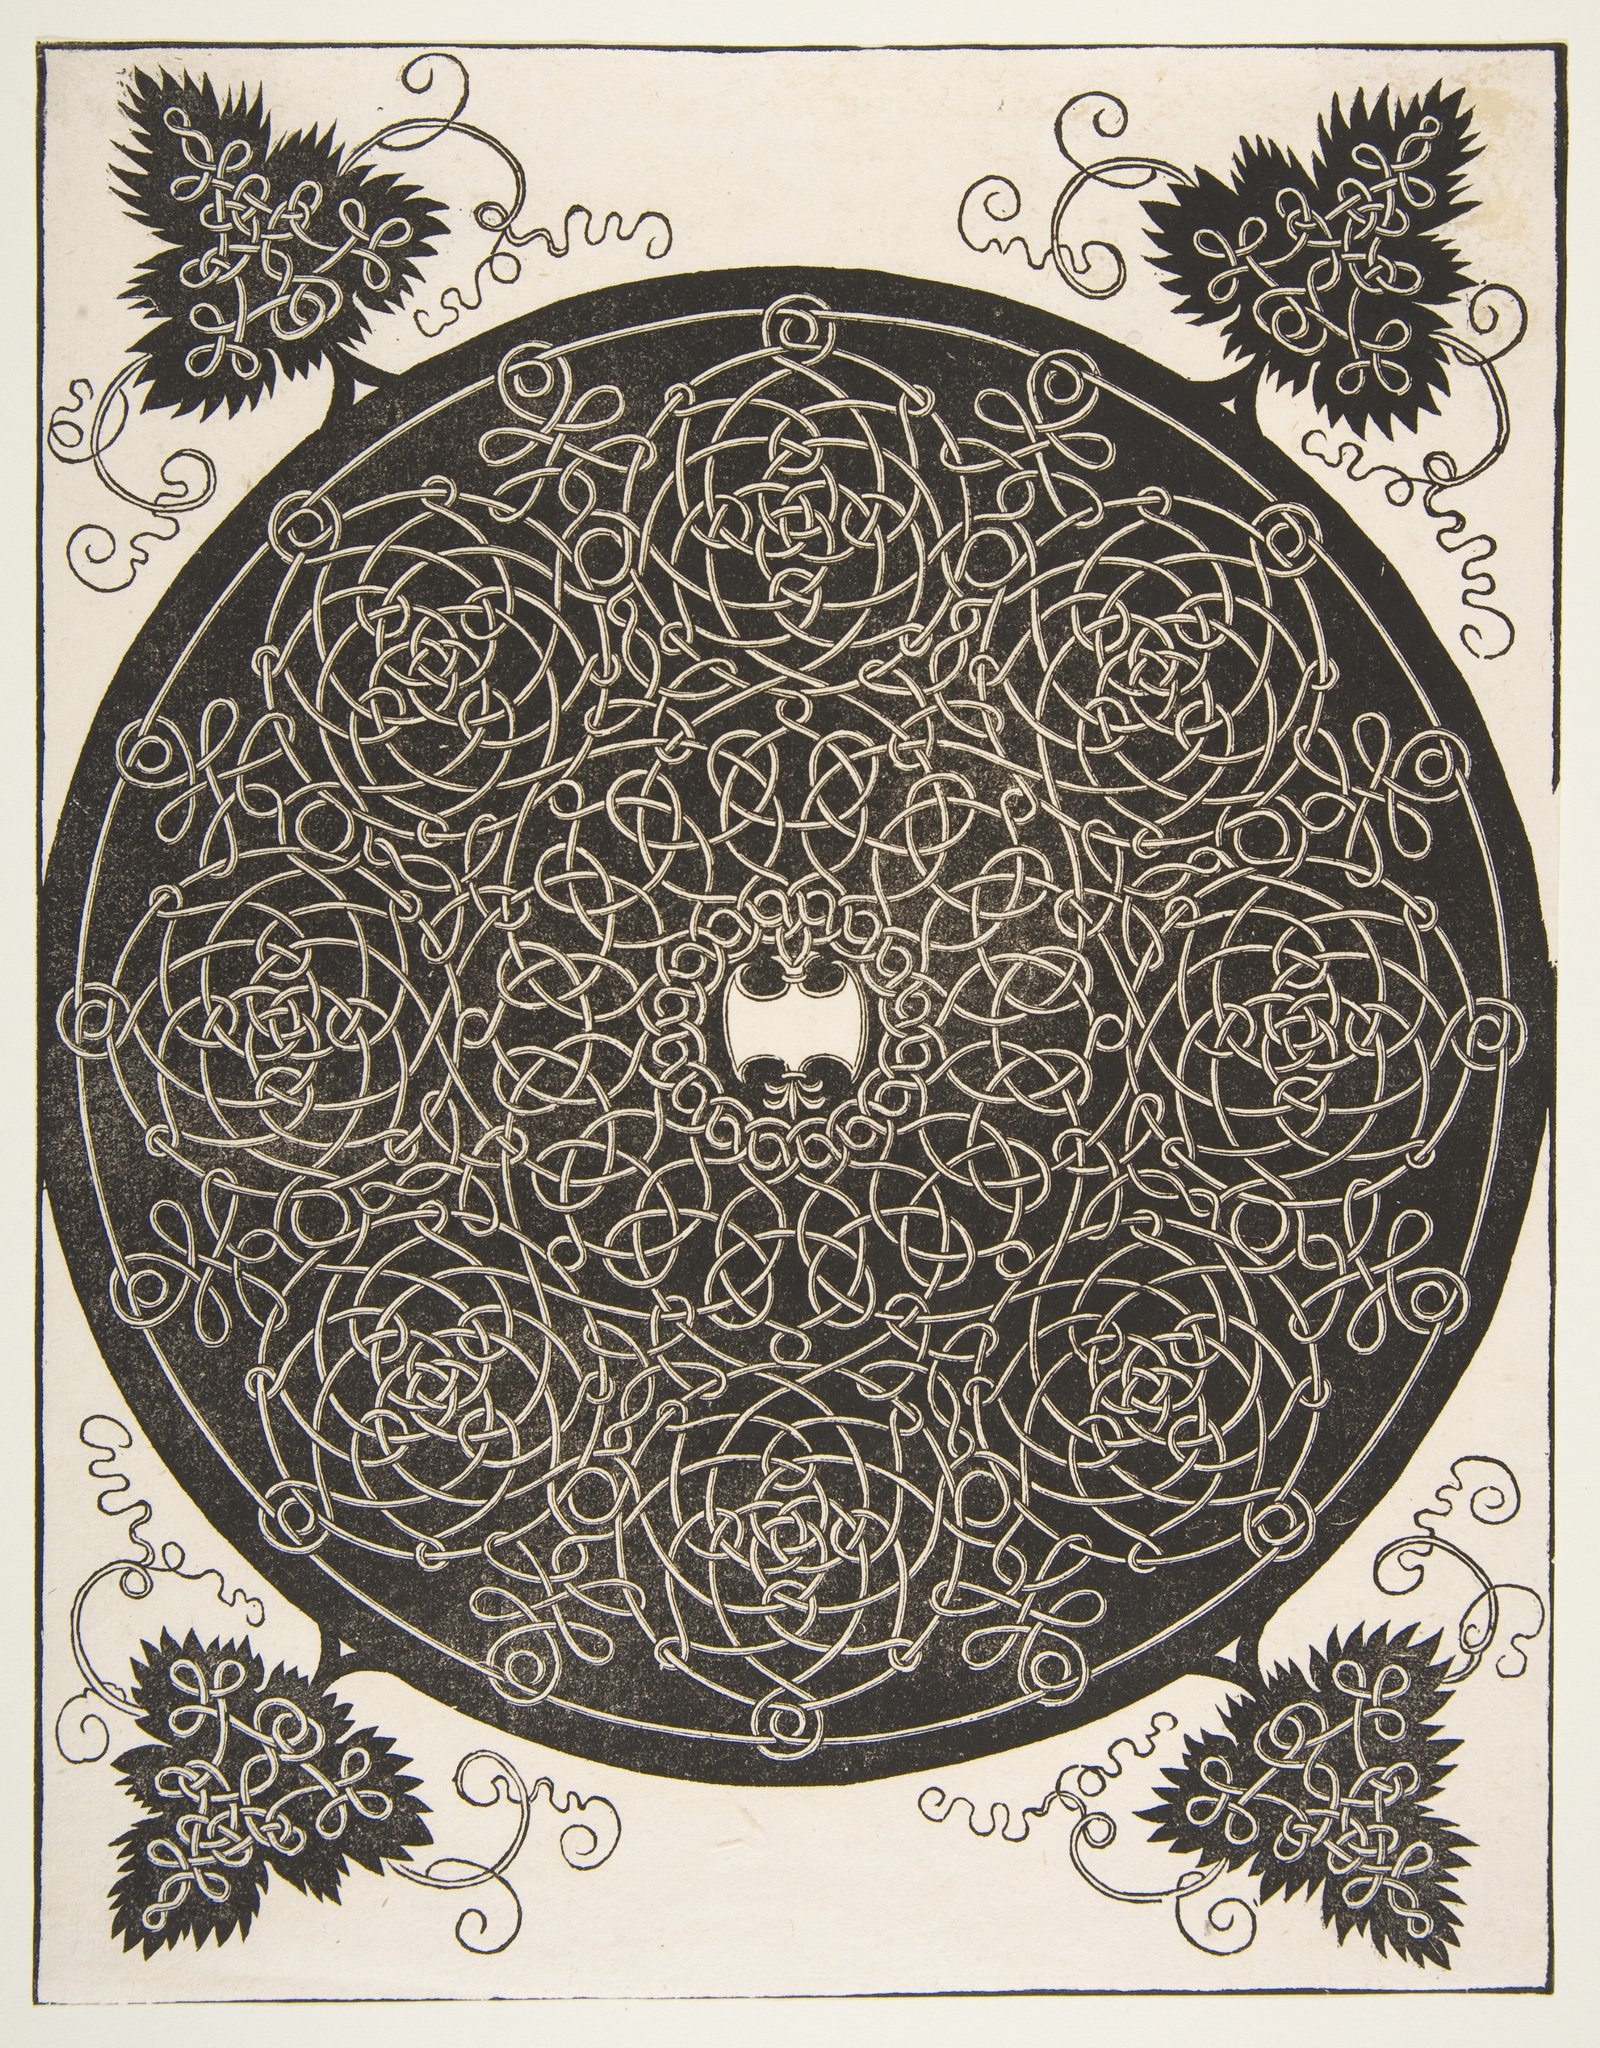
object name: collection ornament architecture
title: “The Third Knot”. Interlaced Roundel with Eight Wreaths and a Scalloped Shield in its Center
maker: albrecht dürer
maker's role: artist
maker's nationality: german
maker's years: 1471-1528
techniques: woodcut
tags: ornament